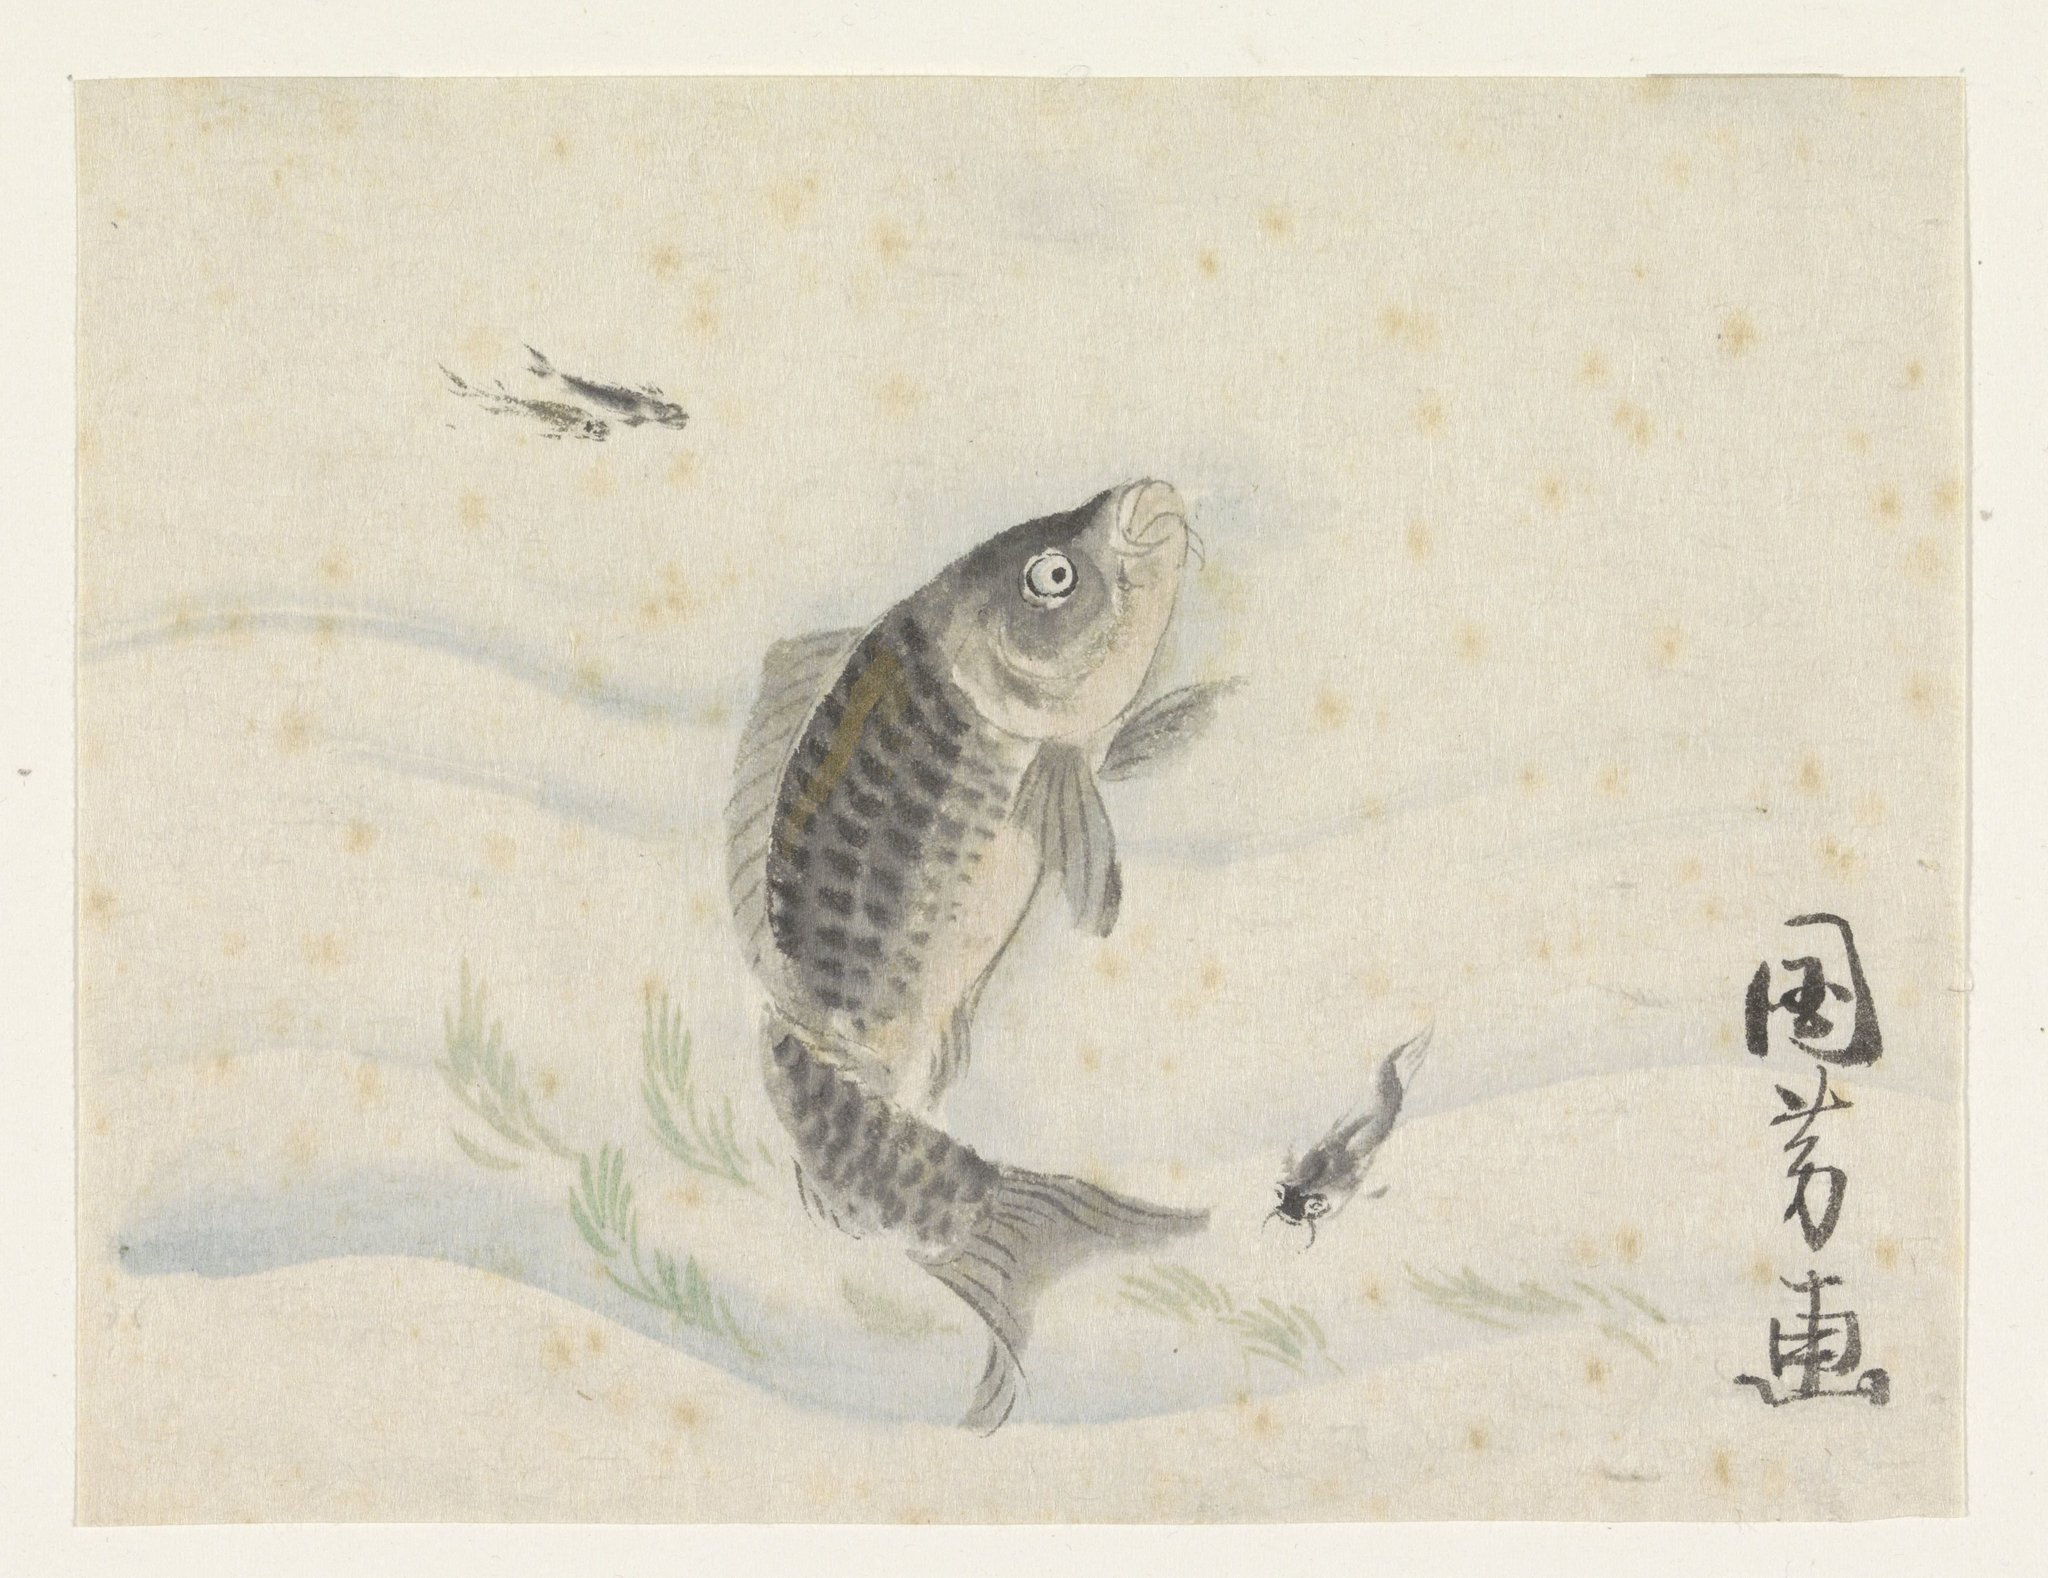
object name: watercolor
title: Karper zwemmend tussen wier en drie visjes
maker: utagawa kuniyoshi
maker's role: draughtsman, print maker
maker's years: 1798-1861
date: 1808-1861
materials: paper, watercolor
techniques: brush